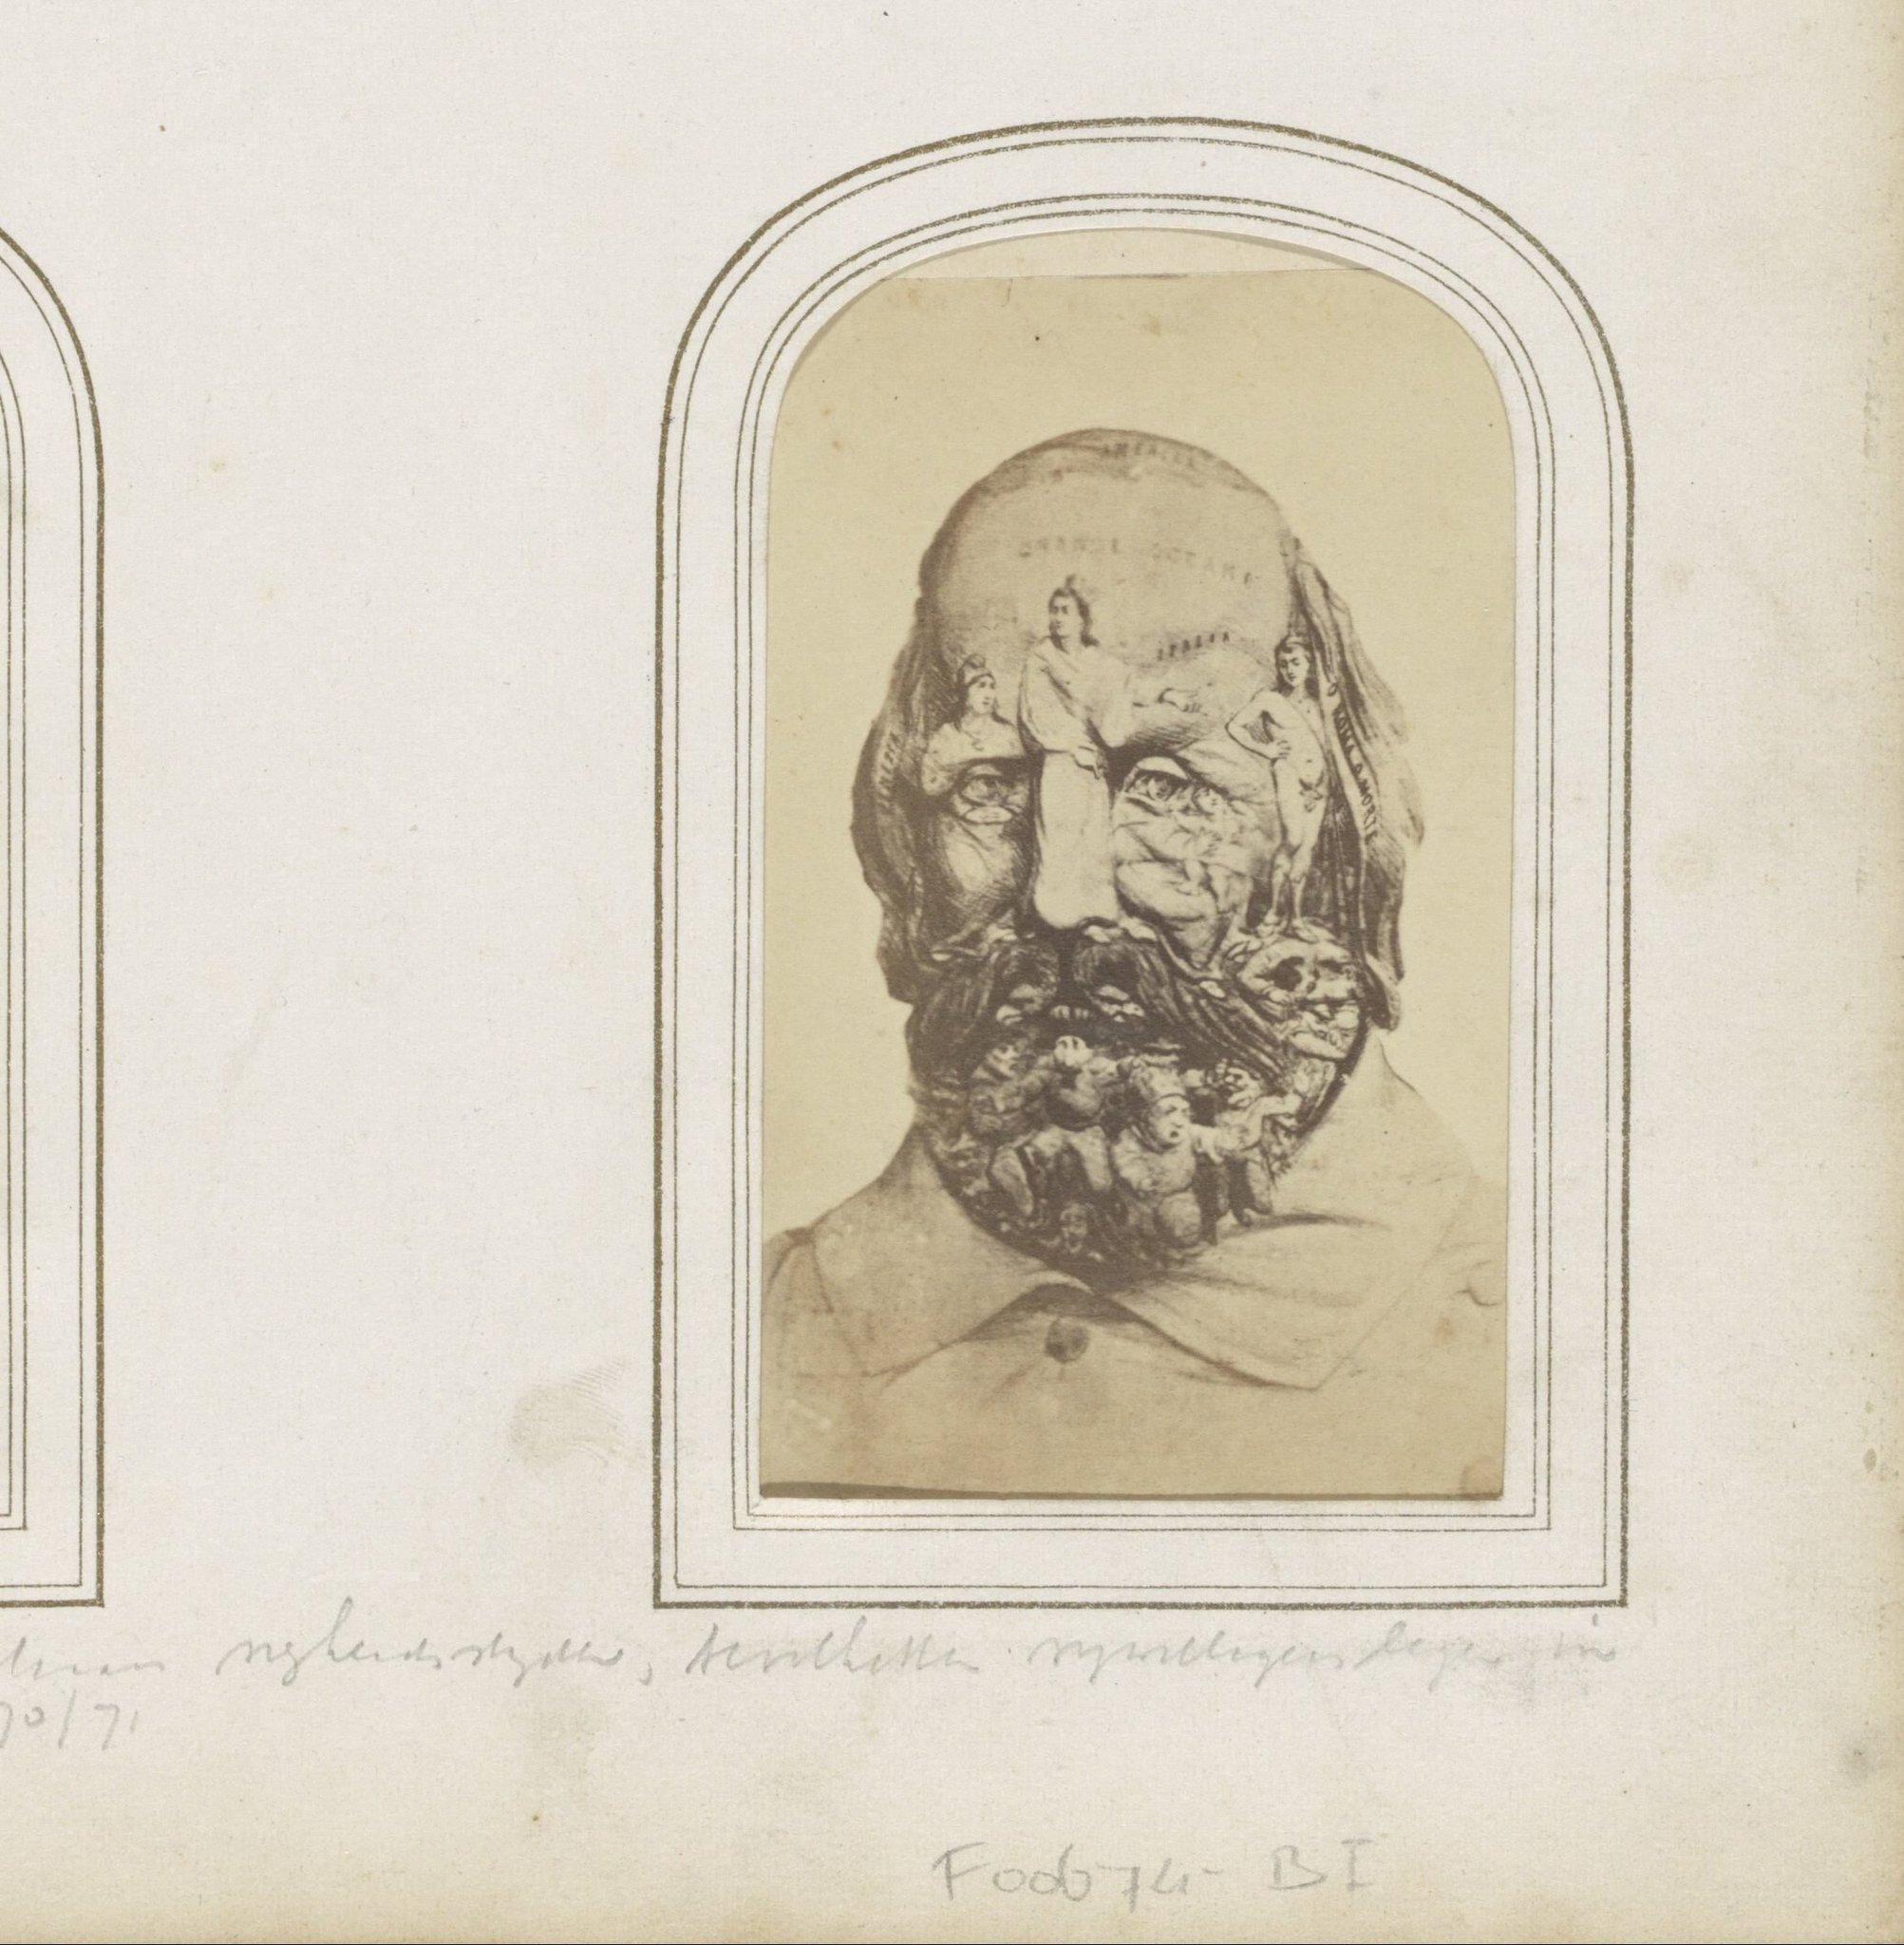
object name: carte de visite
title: Fotoreproductie van (vermoedelijk) een getekende karikatuur van het hoofd van Giuseppe Garibaldi, Italiaans vrijheidsstrijder en politicus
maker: Anonymous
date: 1855-1882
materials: cardboard, paper, photographic support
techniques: albumen print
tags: politician, historical persons, politician, e.g. party leader, political caricatures and satires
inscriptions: inscription: ‘Garibaldi’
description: Onderdeel van Fotoalbum met 123 cartes-de-visite van leden van Europese vorstenhuizen, politici en bekende personen.